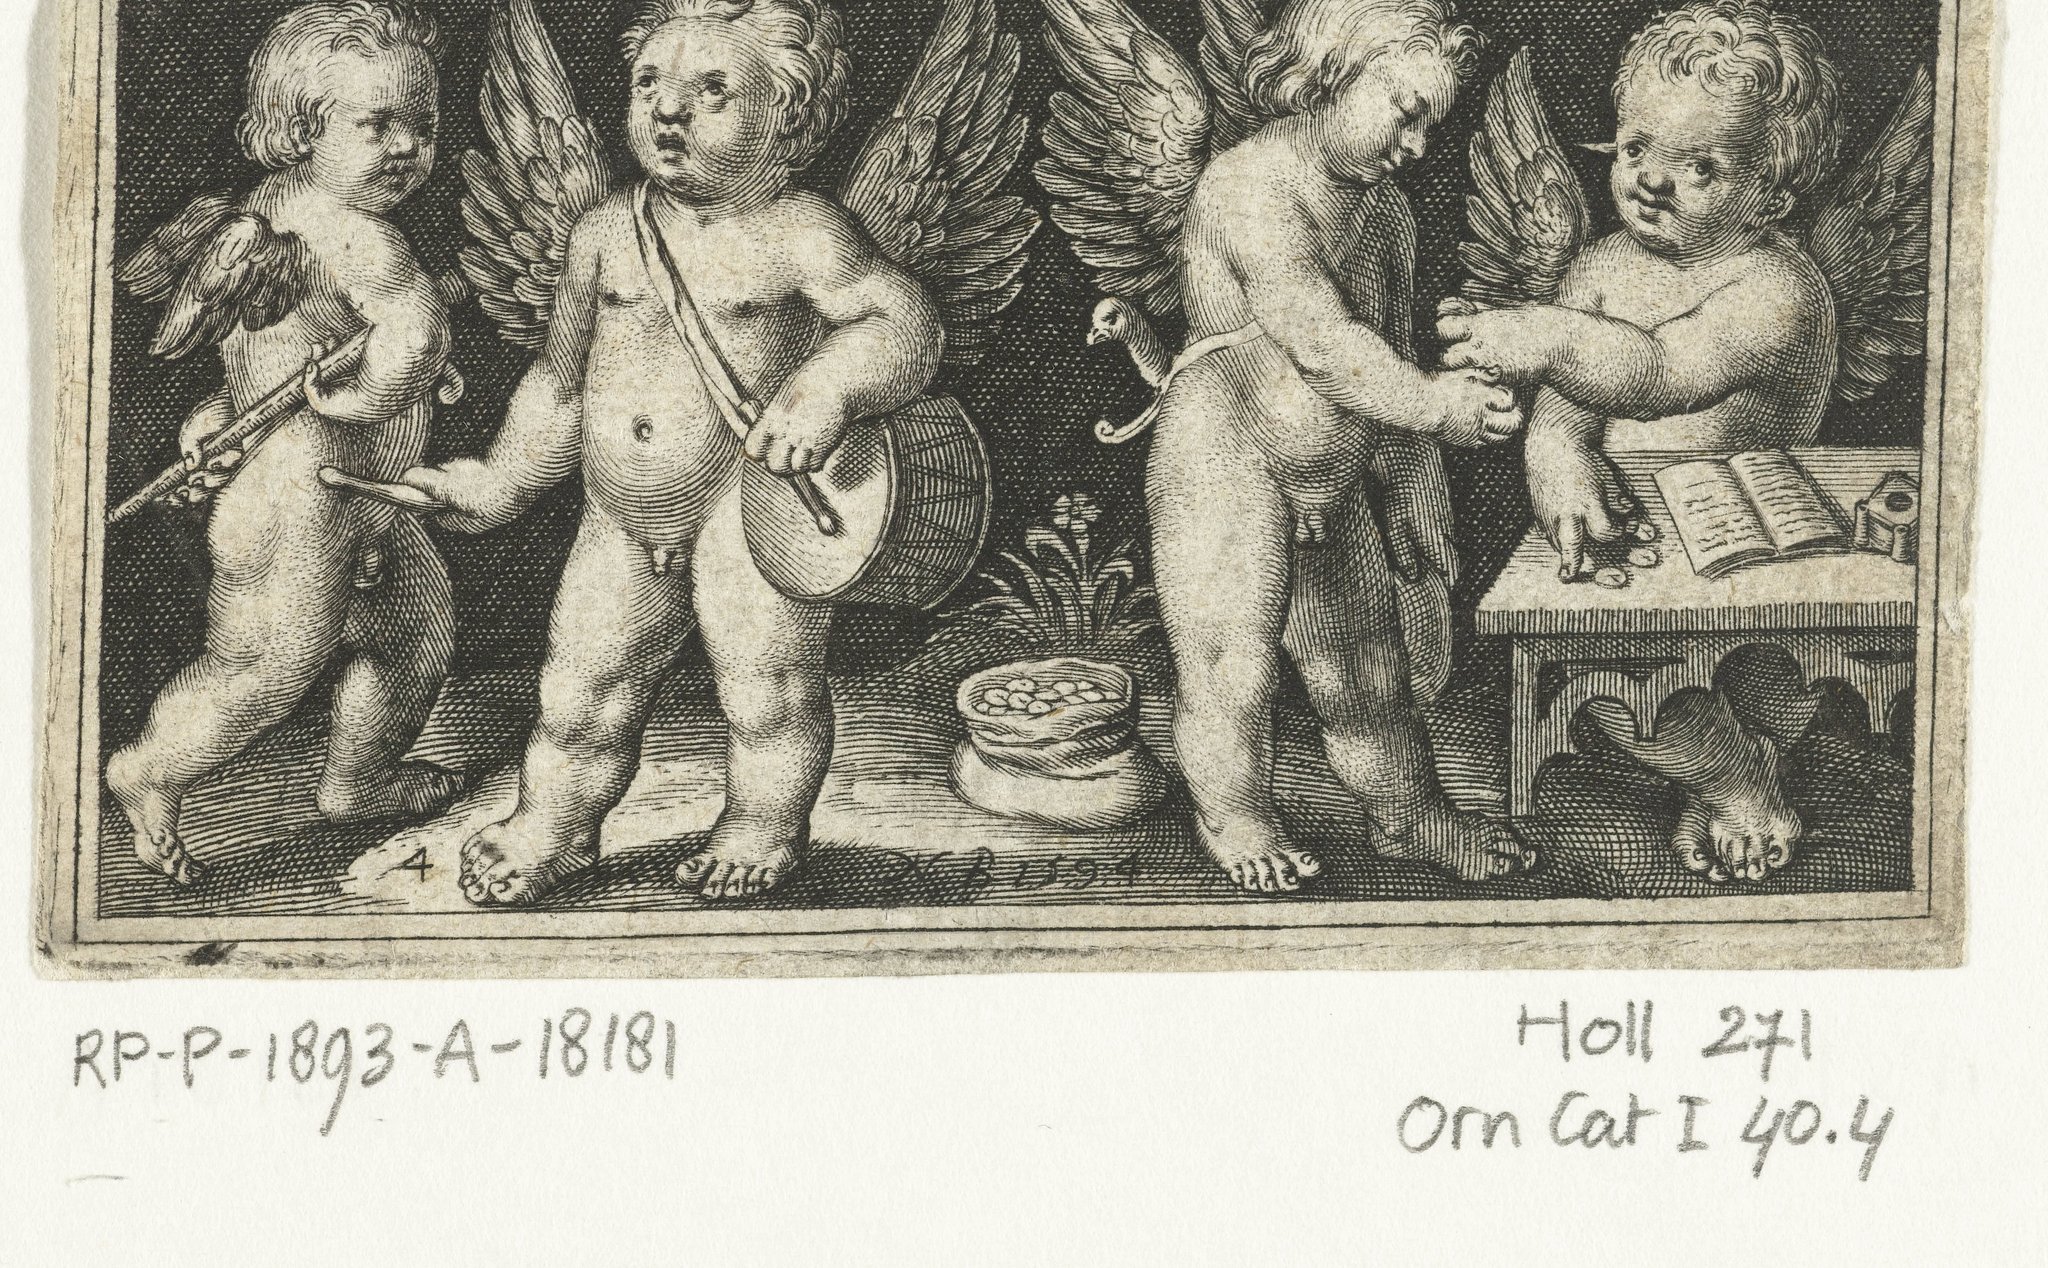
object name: print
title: Twee engeltjes tellen geld en twee engeltjes met rommel en fluit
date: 1594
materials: paper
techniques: engraving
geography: netherlands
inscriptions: collector's mark: Lugt 2228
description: Prent uit serie van zes prenten met Friezen met kinderen, engeltjes en dieren. Hollstein beschrijft deze serie twee keer onder de nrs. 142-147 en 268-273.